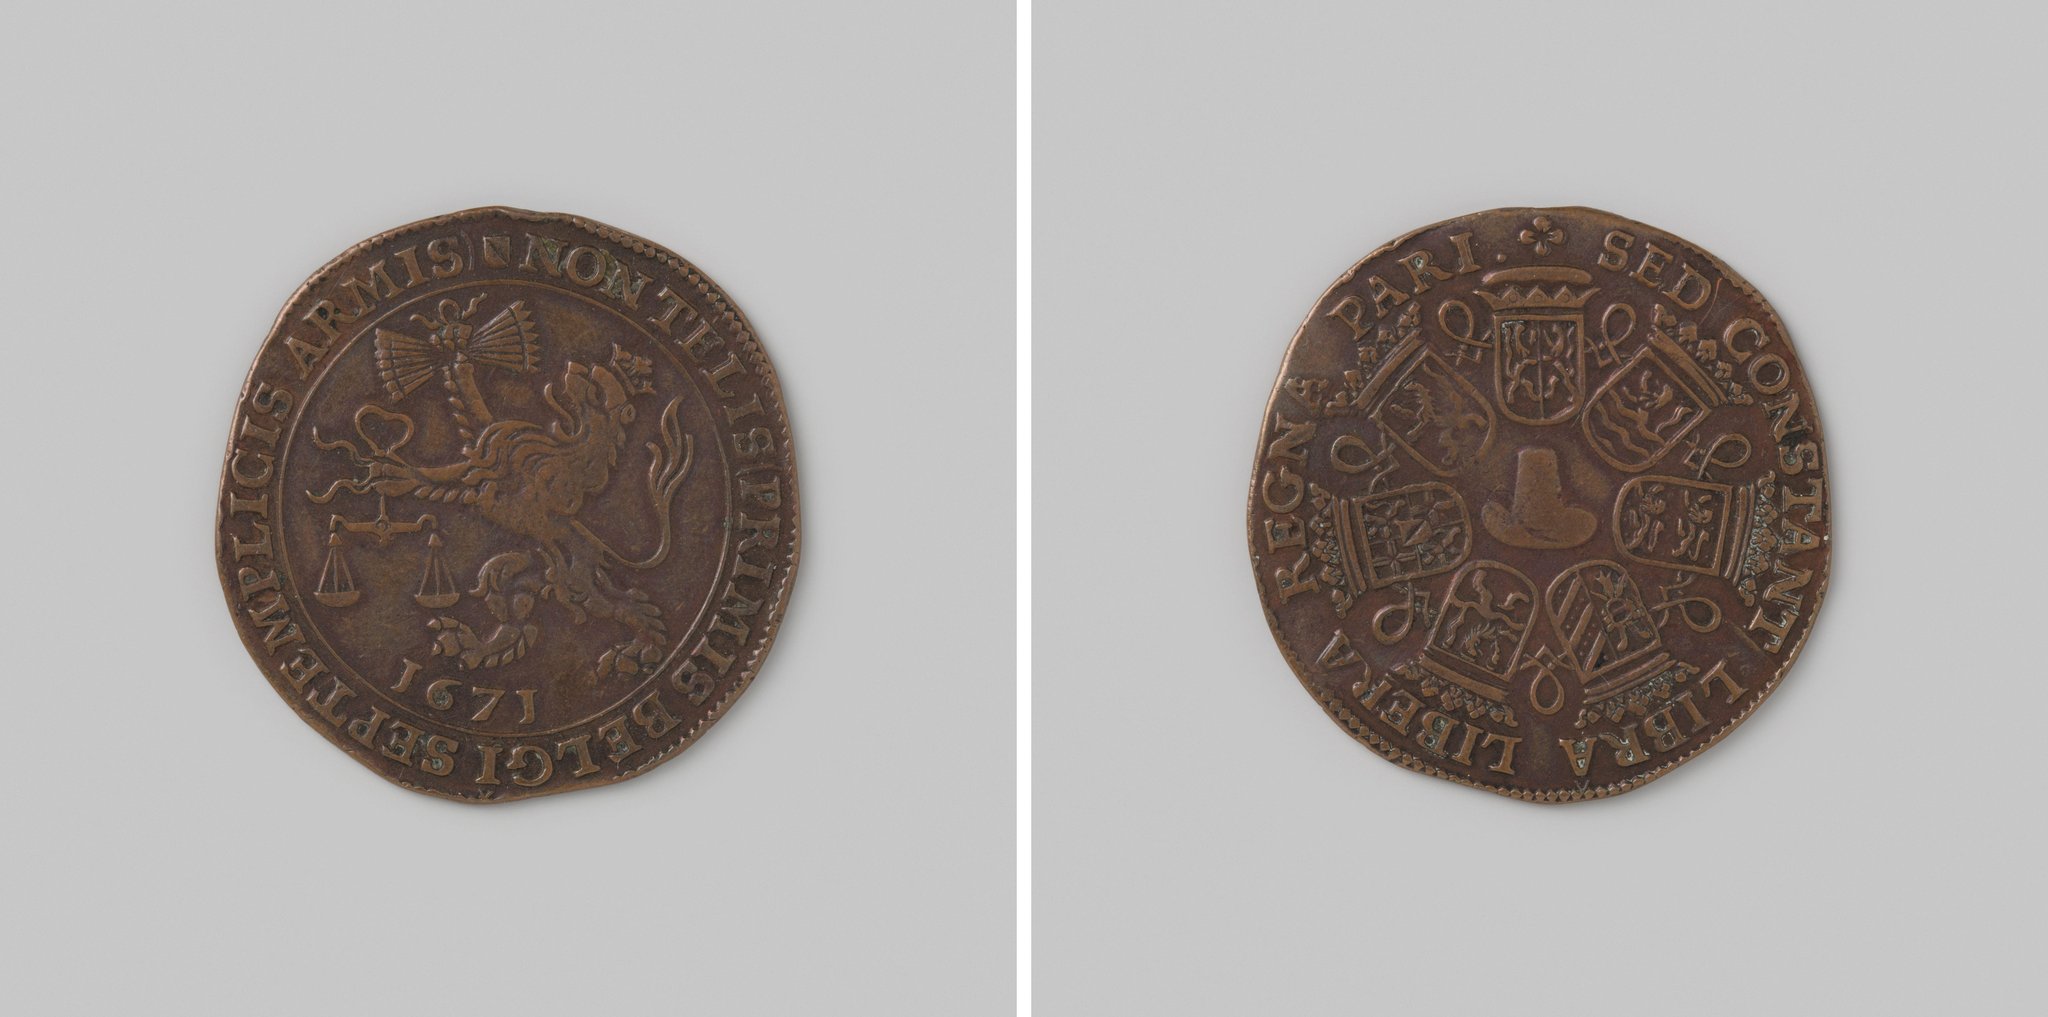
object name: jeton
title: Verlangen naar vrede door de Nederlanden in 1671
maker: Anonymous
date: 1671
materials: copper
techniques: striking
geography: netherlands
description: Geslagen koperen penning. Voorzijde: klimmende leeuw met pijlenbundel en weegschaal in zijn klauwen, onder zijn rechterpoot jaartal (1671), met Latijns omschrift; keerzijde: zeven met lint aan elkaar verbonden wapenschilden (van de zeven Nederlandse gewesten), waarbinnen een hoed (vrijheidshoed), met Latijns omschrift.